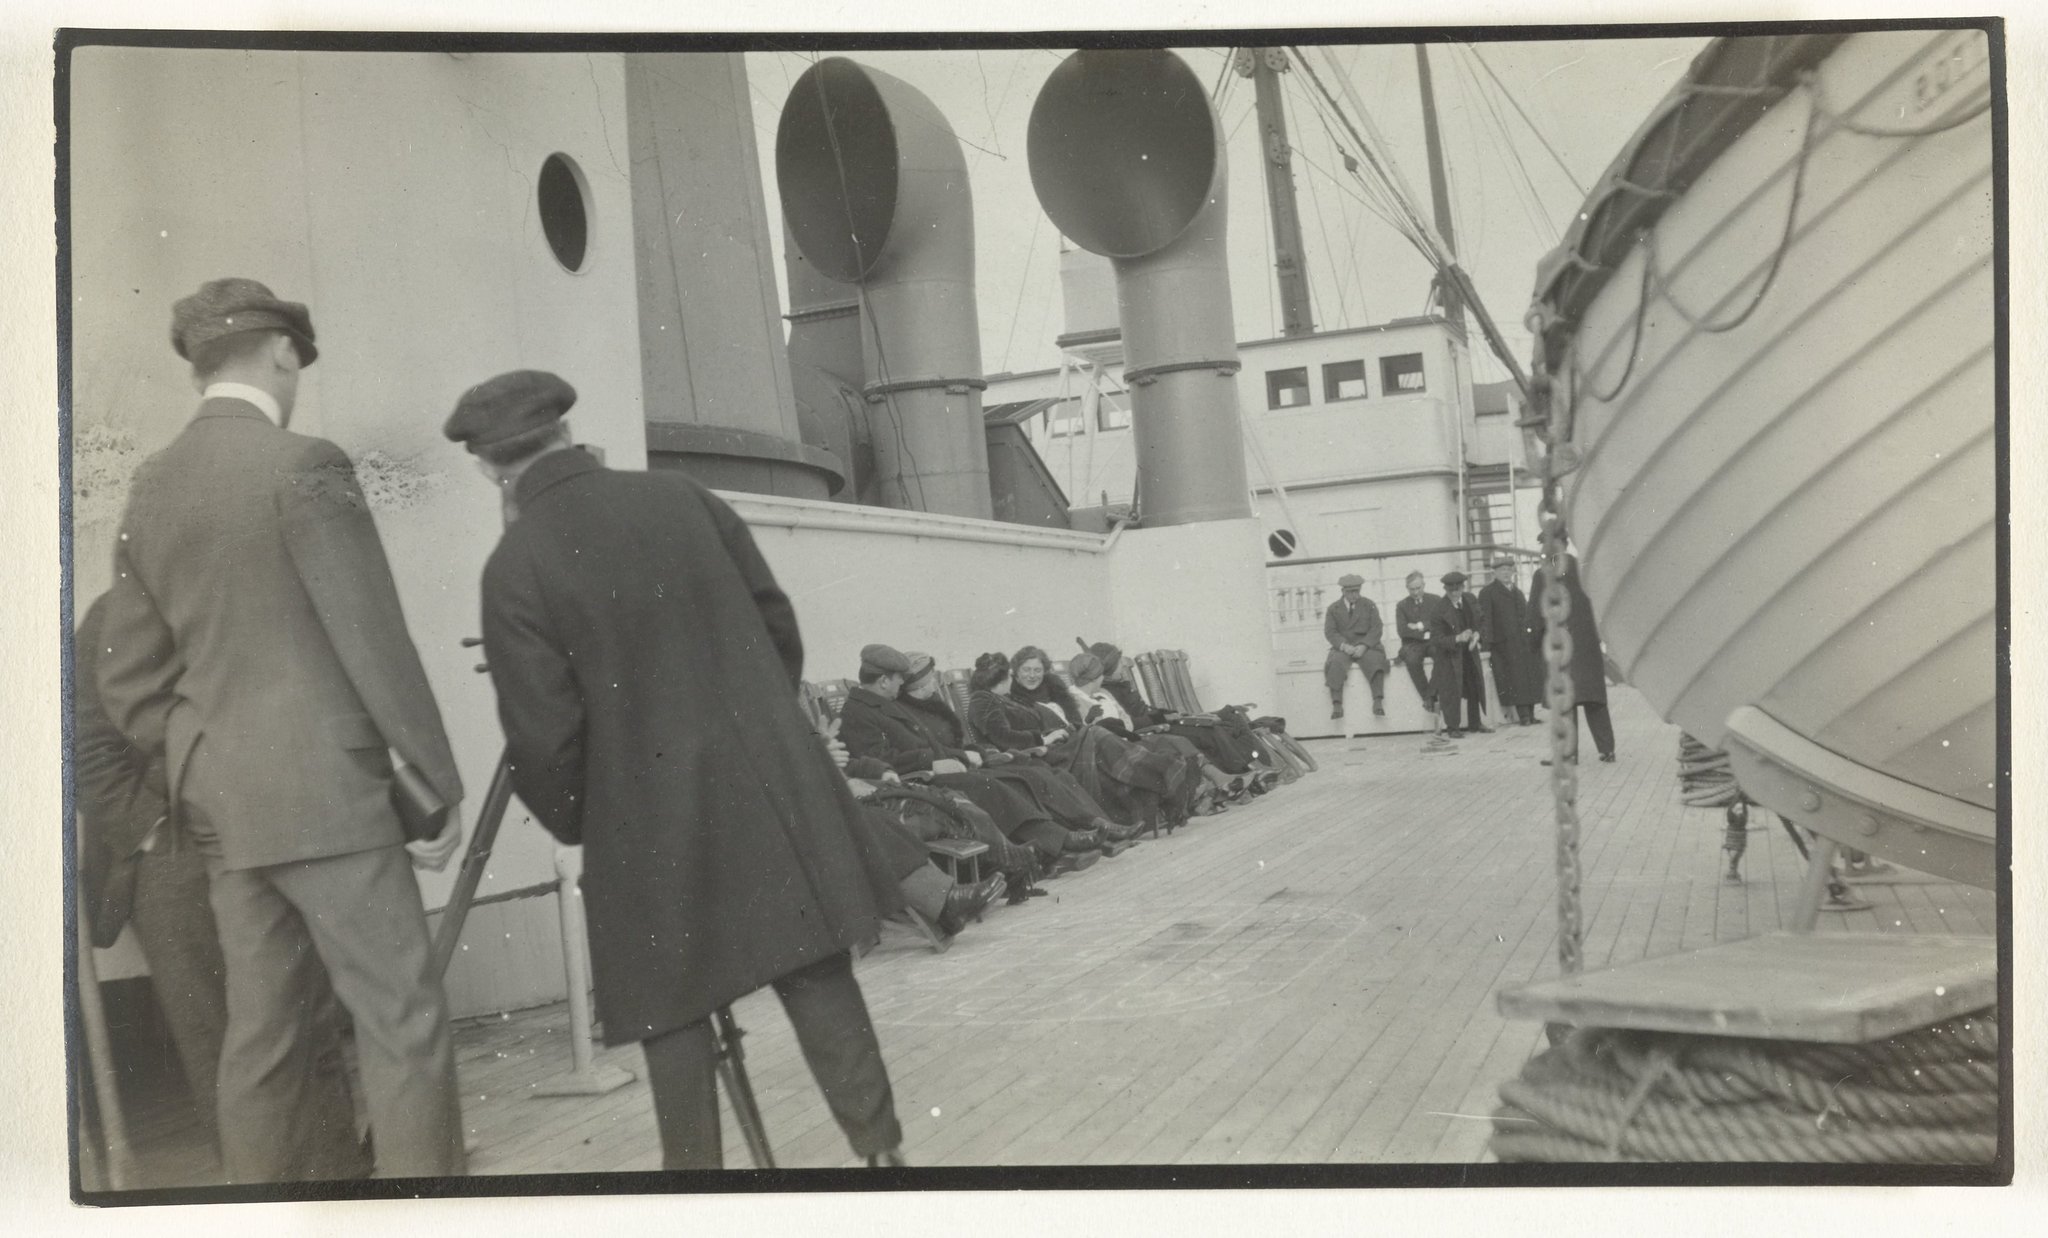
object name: photograph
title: Aan boord van schip naar New York in Eerste Wereldoorlog, filmer temidden van de gasten aan dek gaat filmen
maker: Anonymous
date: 1914-1918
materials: paper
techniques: gelatin silver print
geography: netherlands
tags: ships (in general)